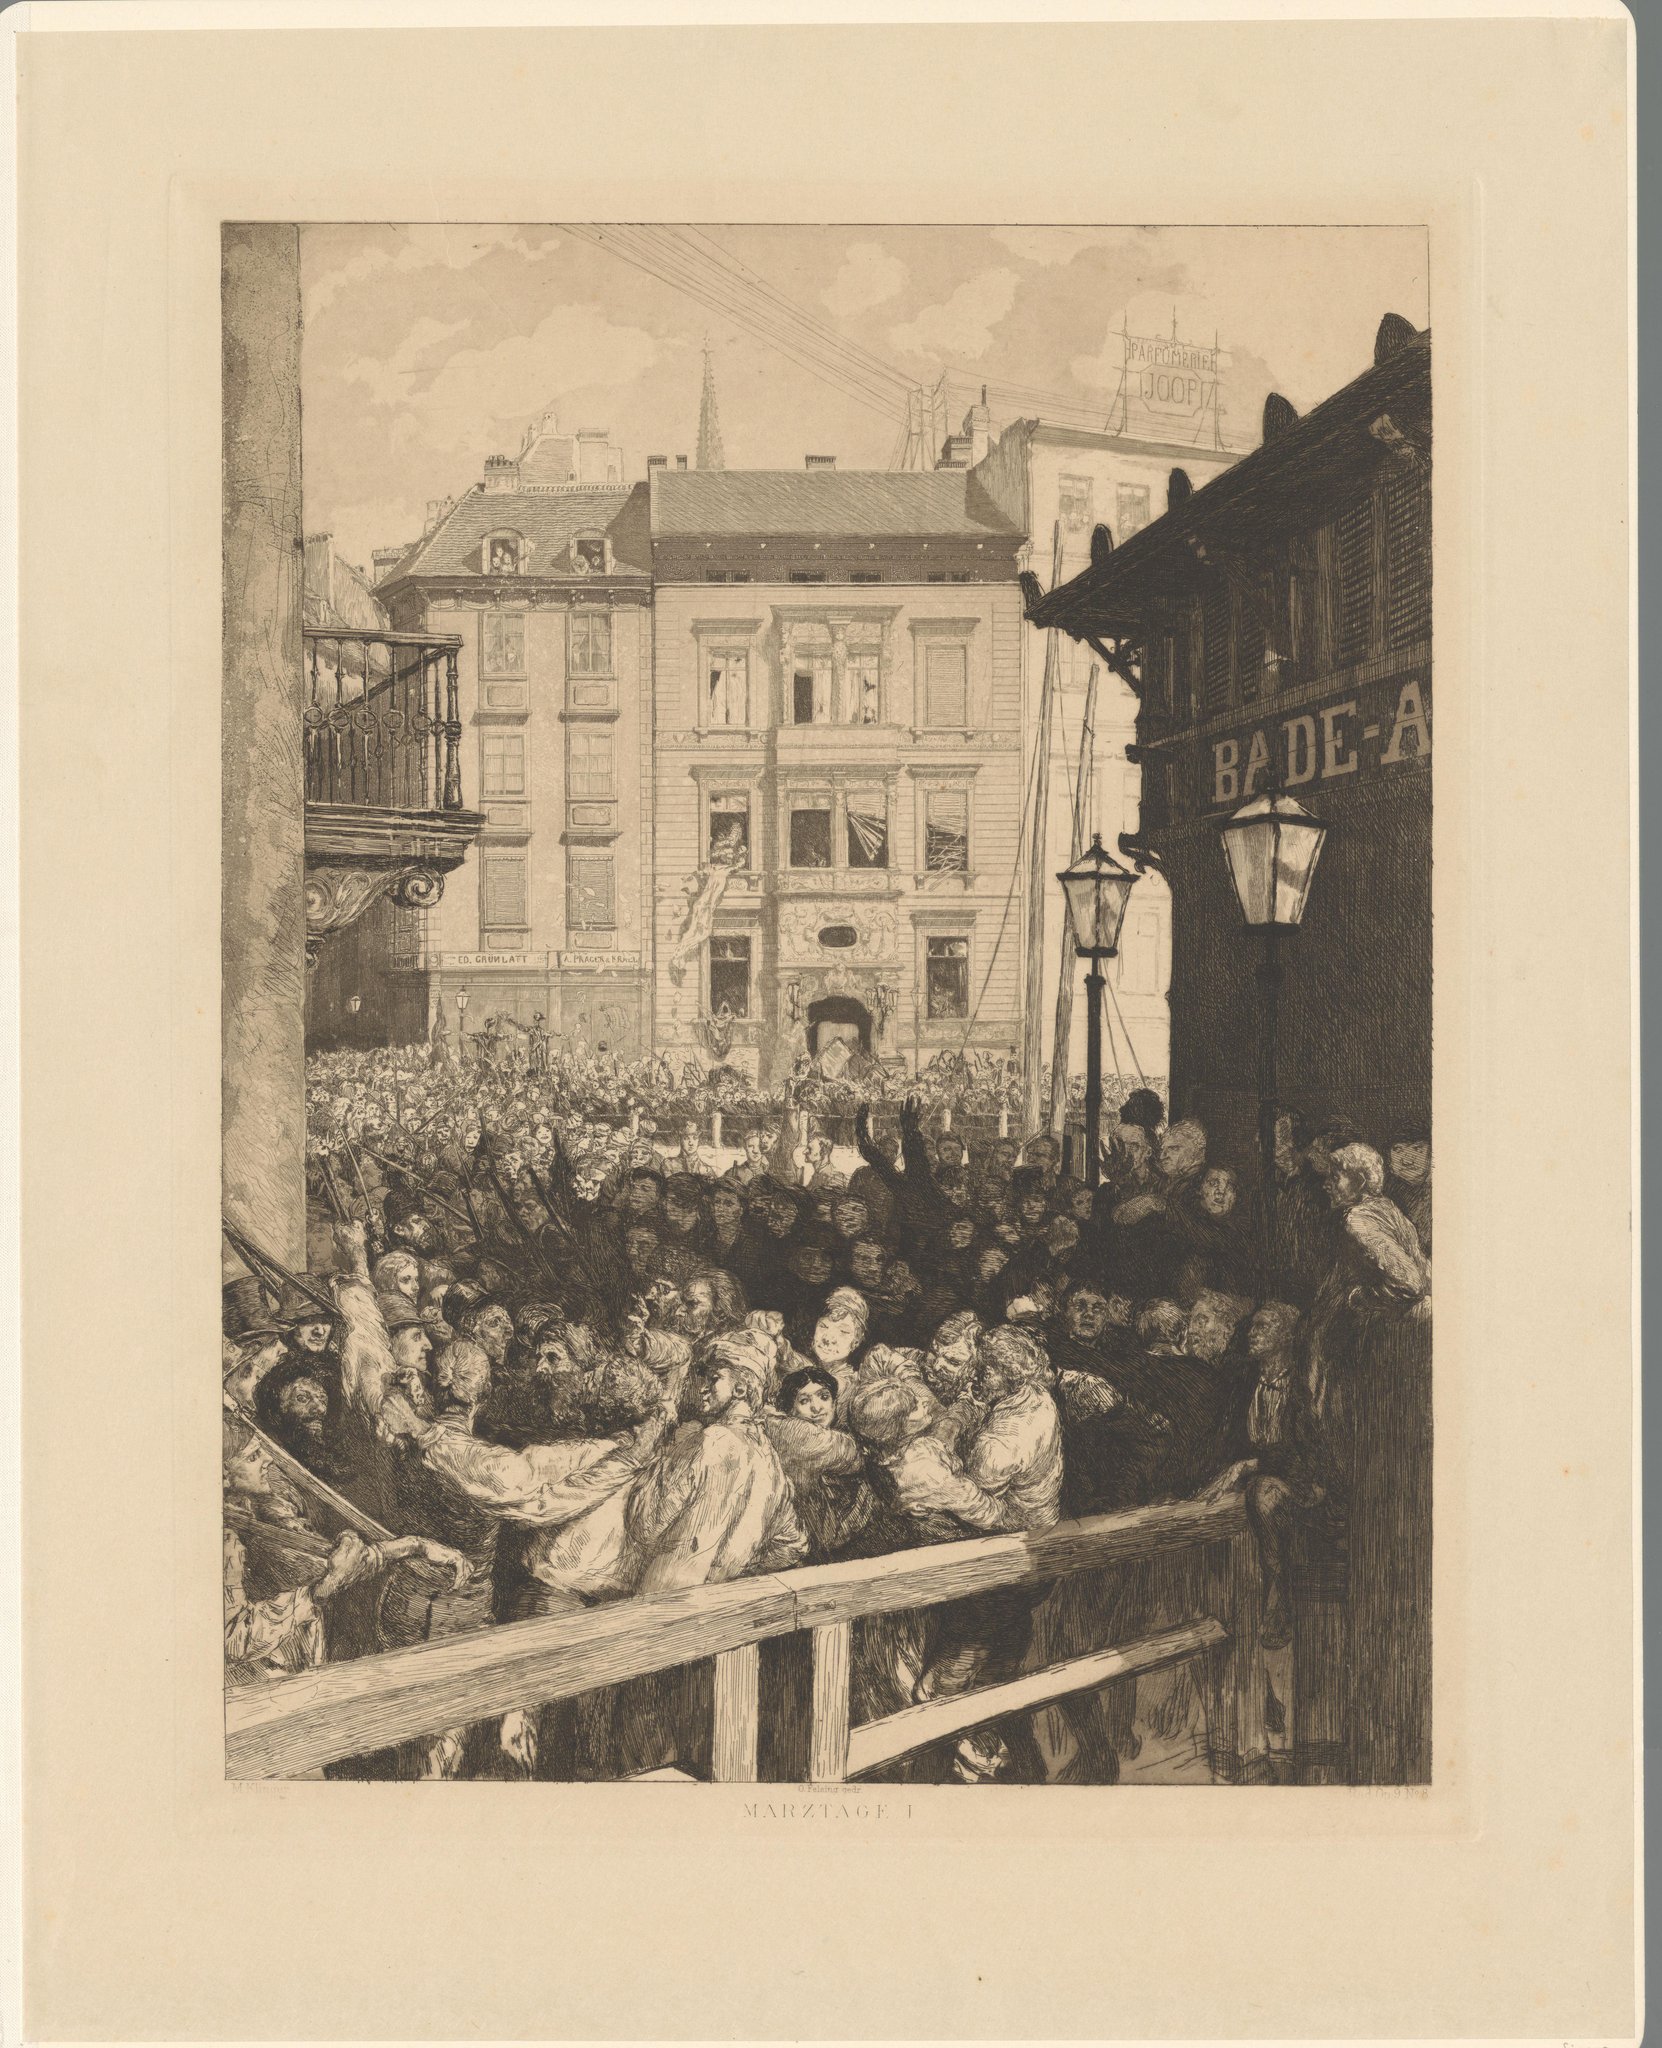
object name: print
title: Märztage I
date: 1883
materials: paper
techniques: aquatint, drypoint, etching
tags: street-fights, riots, berlin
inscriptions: collector's mark: Lugt 2760, collector's mark: Lugt 2228, annotation: ‘Rad. Op. 9 No. 8’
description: Deze prent hoort bij een serie getitleld 'Dramen (Opus IX) van tien prenten door Max Klinger, geïnspireerd door teksten van Emil Zola, met zes maatschappelijke tragediën ten tijde van de industriële revolutie in Duitsland rond 1880. Vooral thema's van jaloezie, sociaal klassenverschil, ellende en de melancholie van industrialisatie in Berlijn worden belicht. De zin 'Doch uns ist gegeben auf keiner Stätte zu ruh'n' (vrij vertaald: 'We krijgen toch nergens rust') uit het gedicht 'Schicksalslied' door Friedrich Hölderlin vormt de onderliggende boodschap van deze serie. De prenten zijn in 1883 gedrukt door Otto Felsing, in vijf edities en 200 sets.